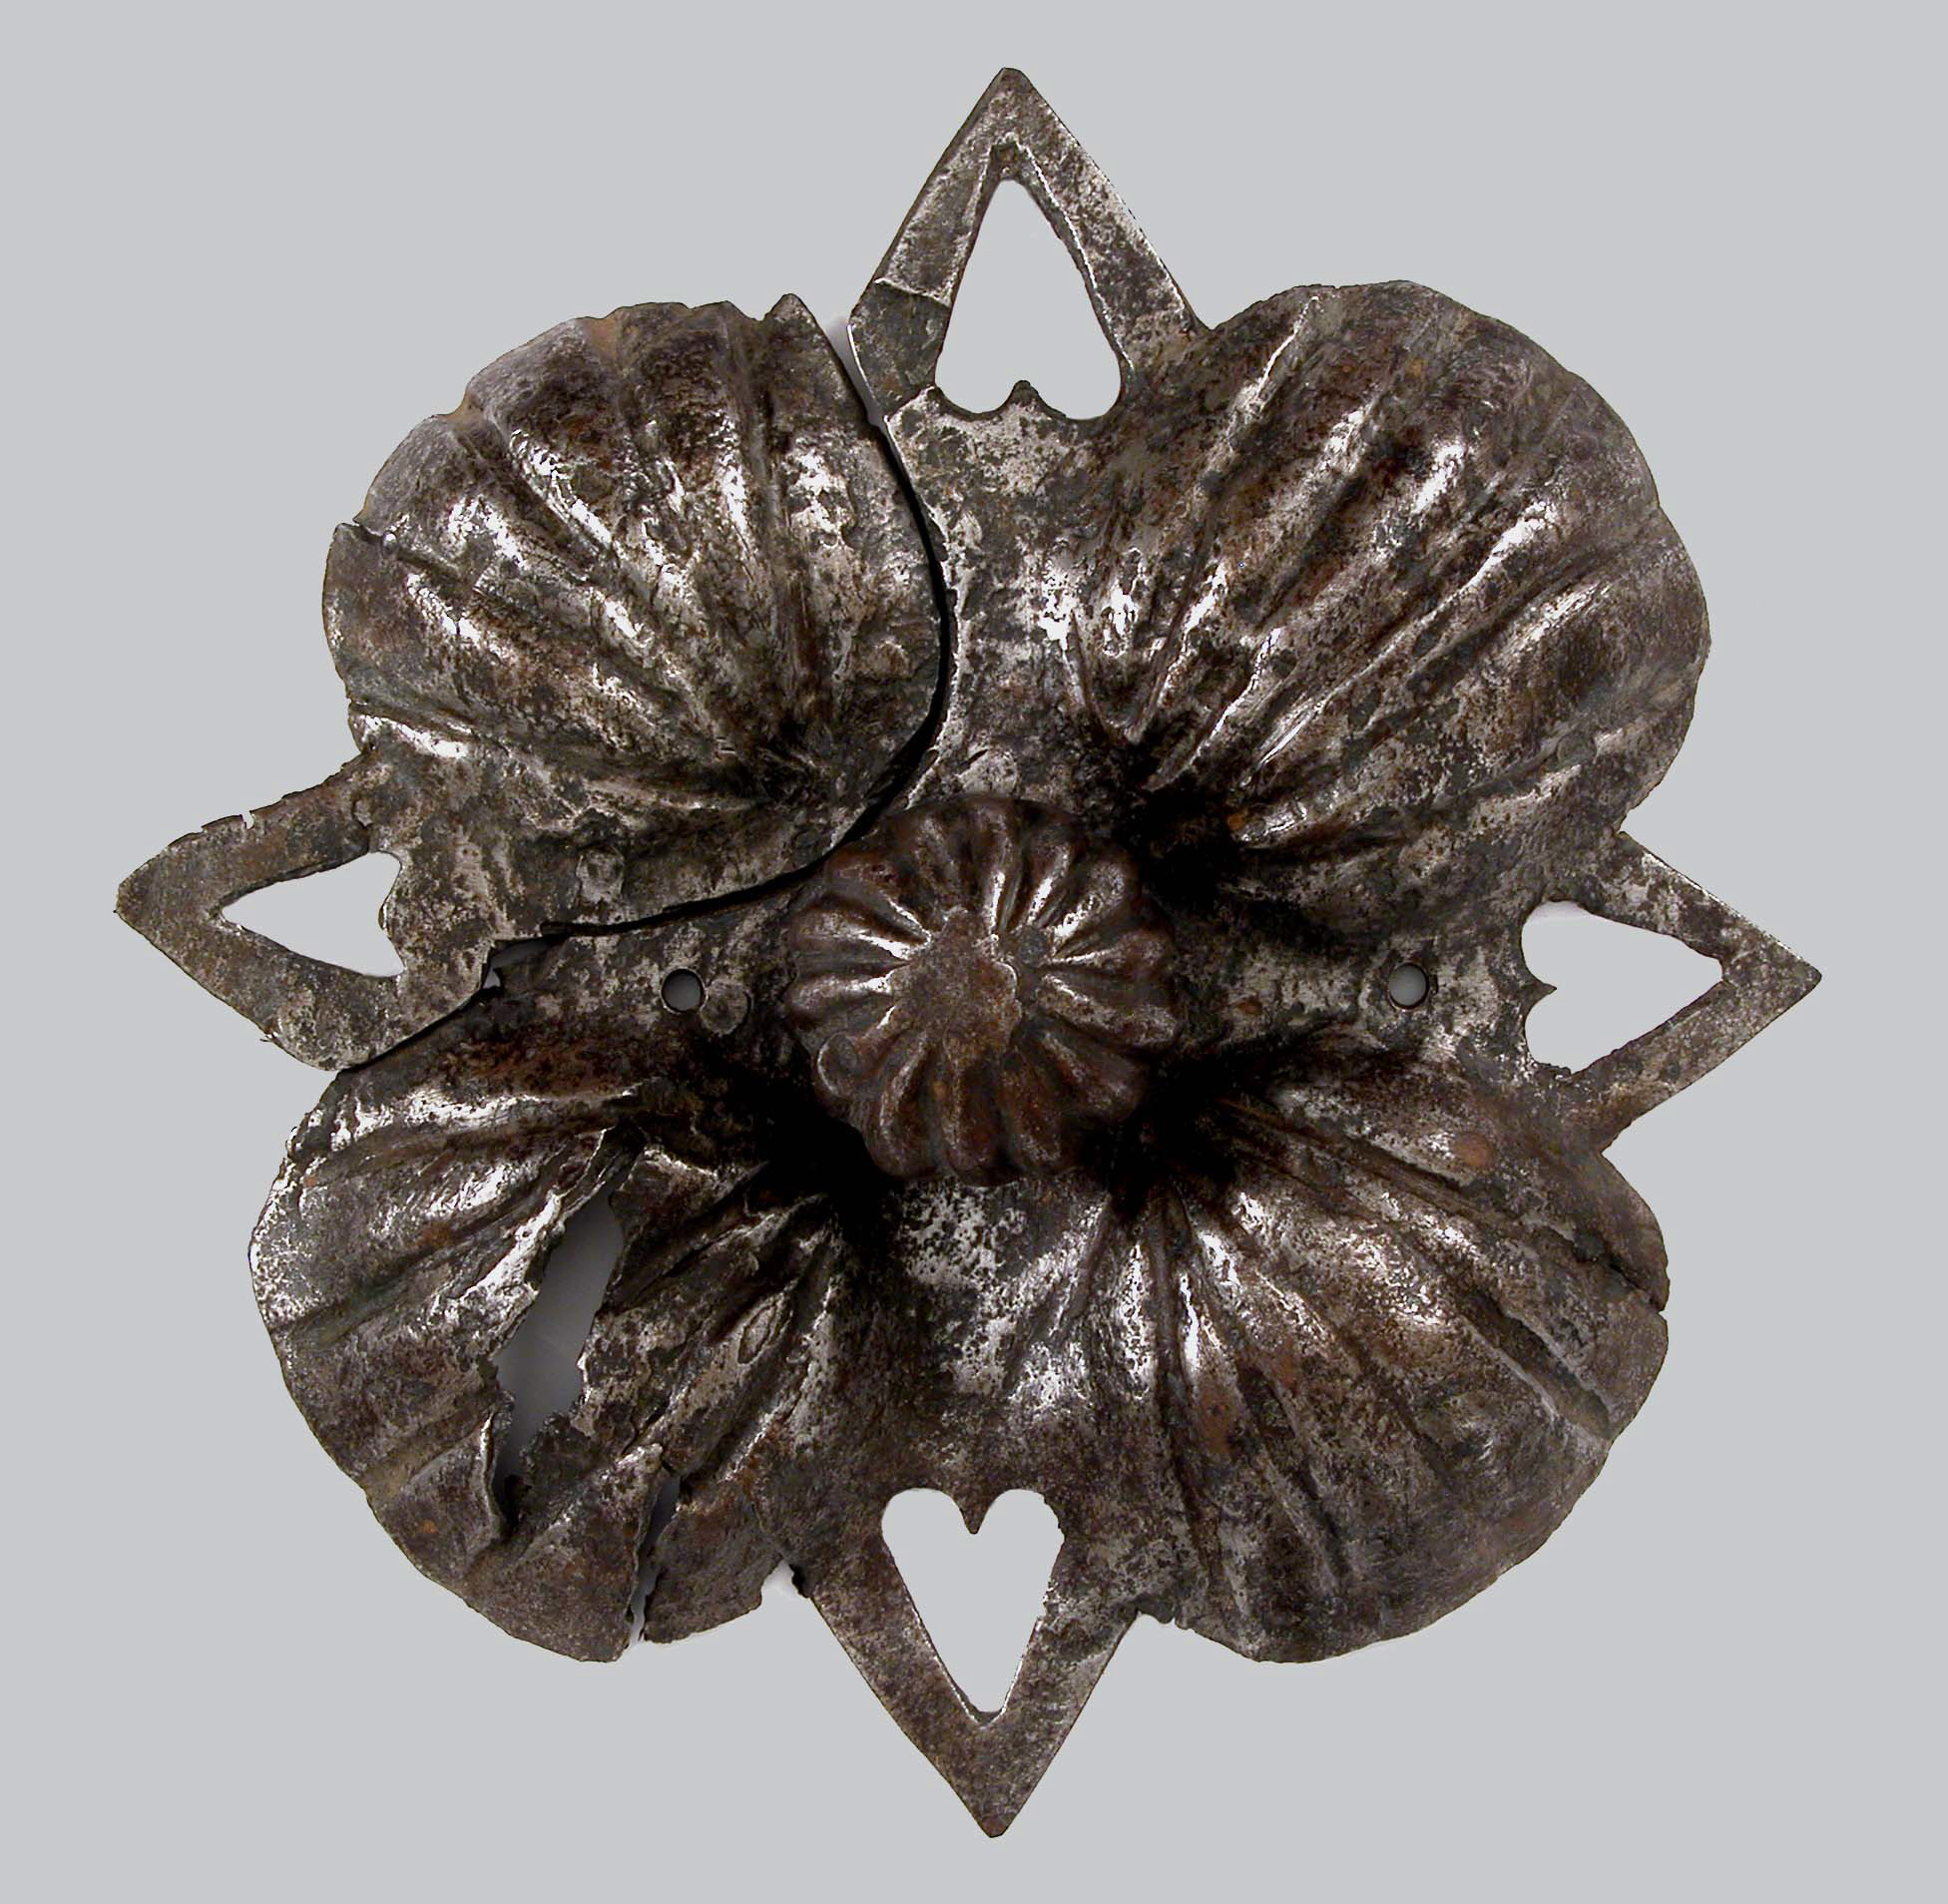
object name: door bos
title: Door Boss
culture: european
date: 1401-1600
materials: iron